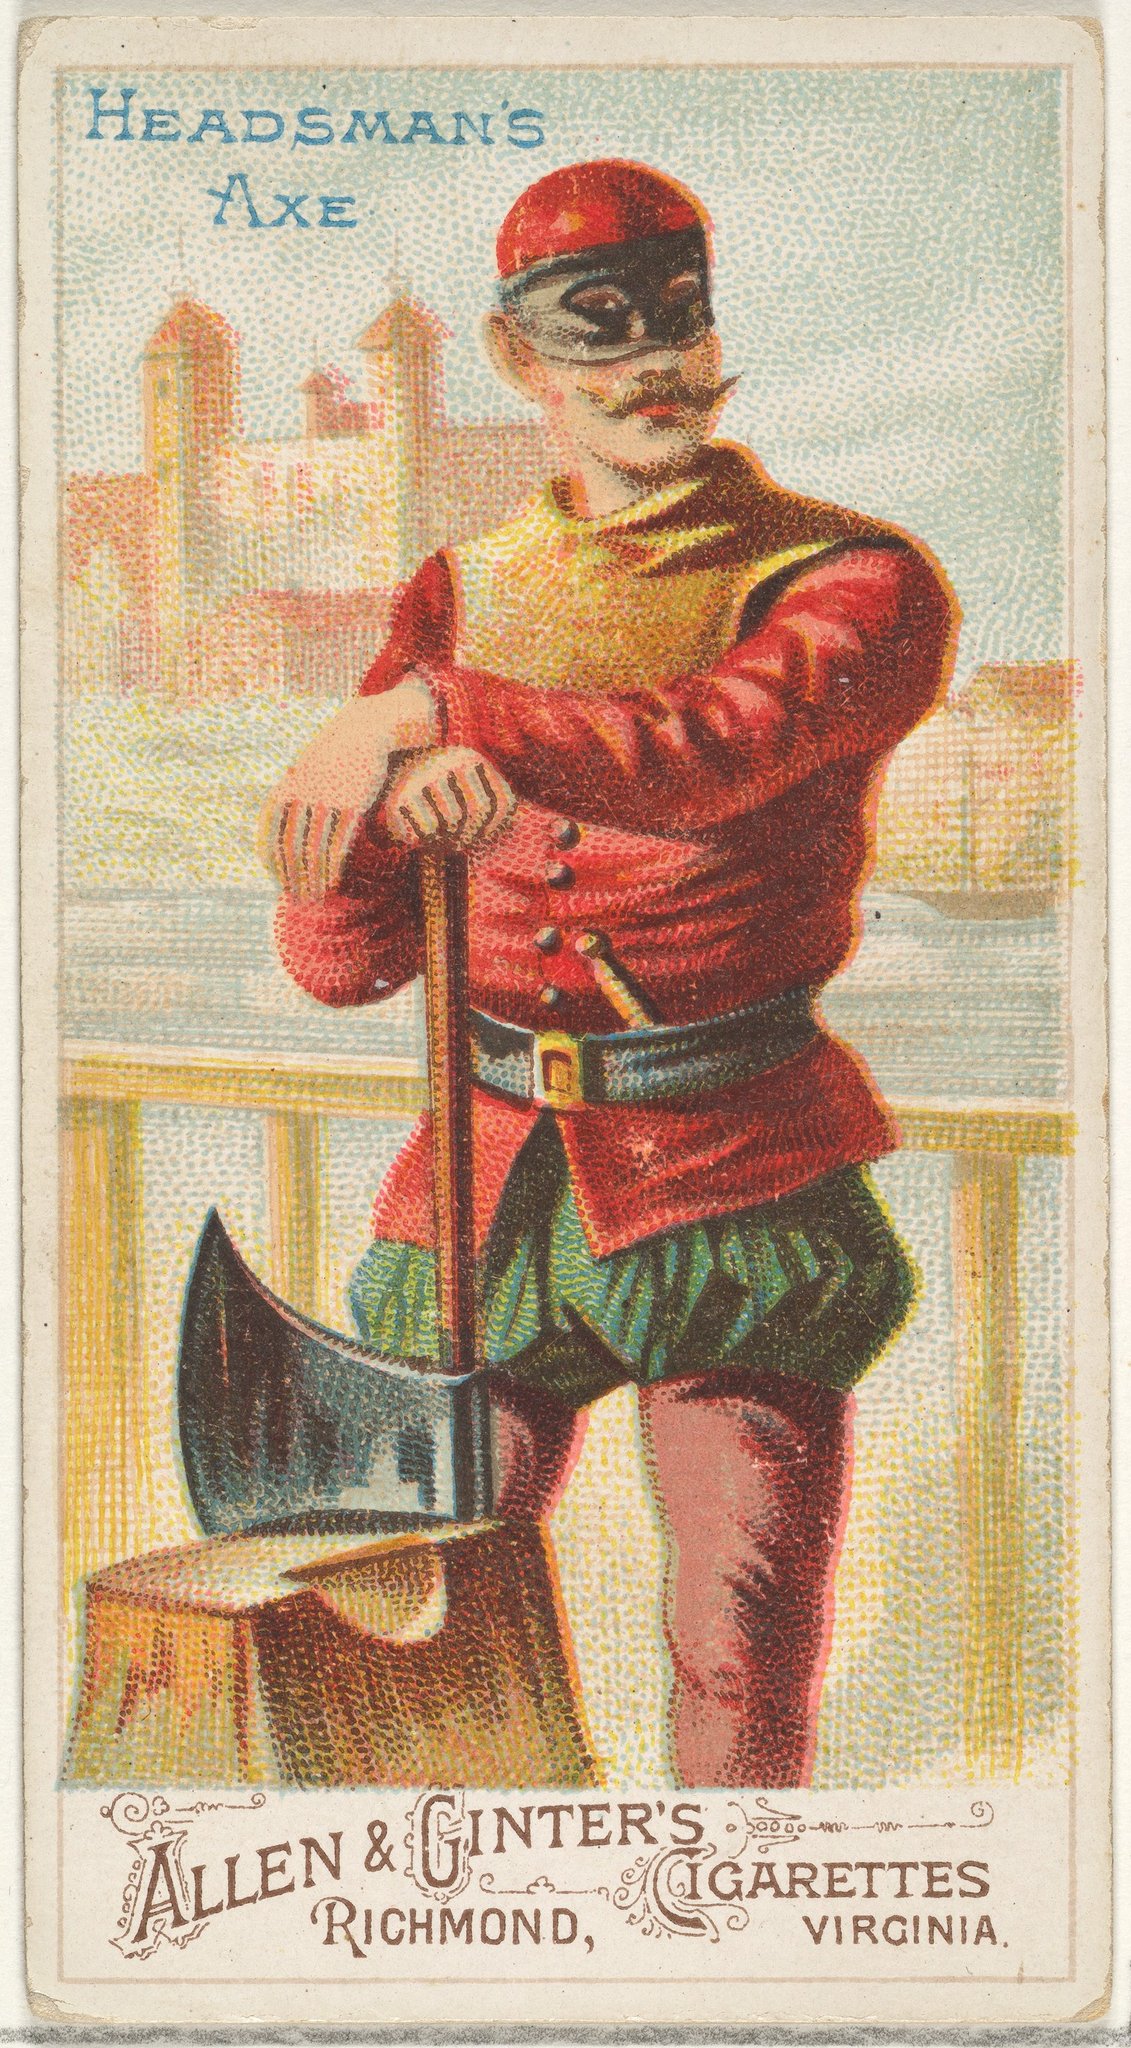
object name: print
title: Headsman's Axe, from the Arms of All Nations series (N3) for Allen & Ginter Cigarettes Brands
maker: allen & ginter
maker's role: publisher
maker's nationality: american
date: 1887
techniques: color lithograph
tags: men,axes